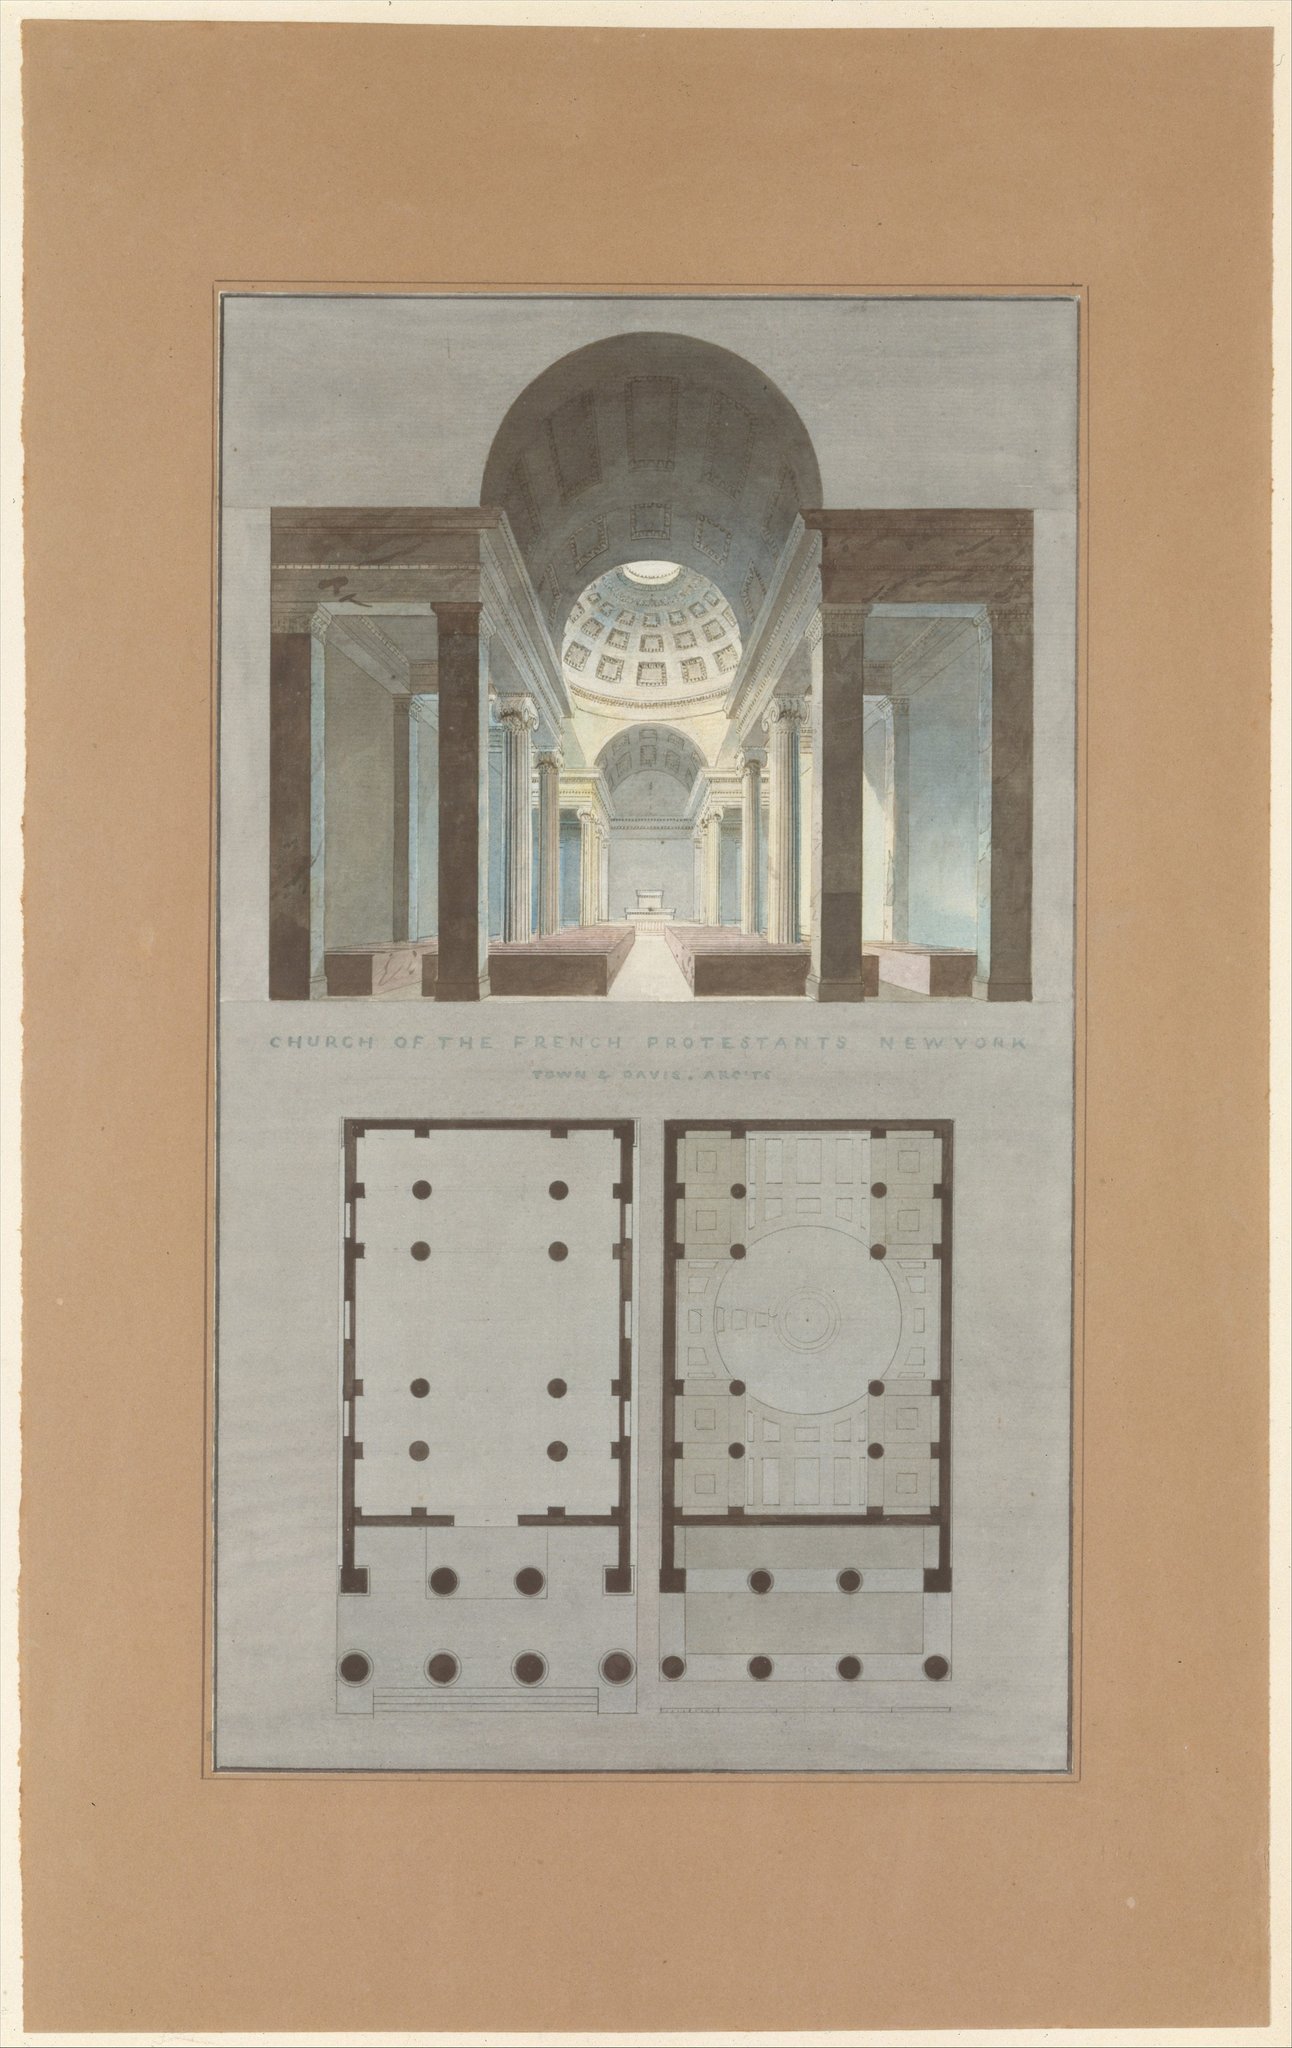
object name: drawing ornament architecture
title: Church of the French Protestants (Eglise Français du Saint Esprit), New York (section and plan)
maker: alexander jackson davis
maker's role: artist and architect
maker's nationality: american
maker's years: 1803-1892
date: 1831-1834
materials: graphite, ink, watercolor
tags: architecture,churches